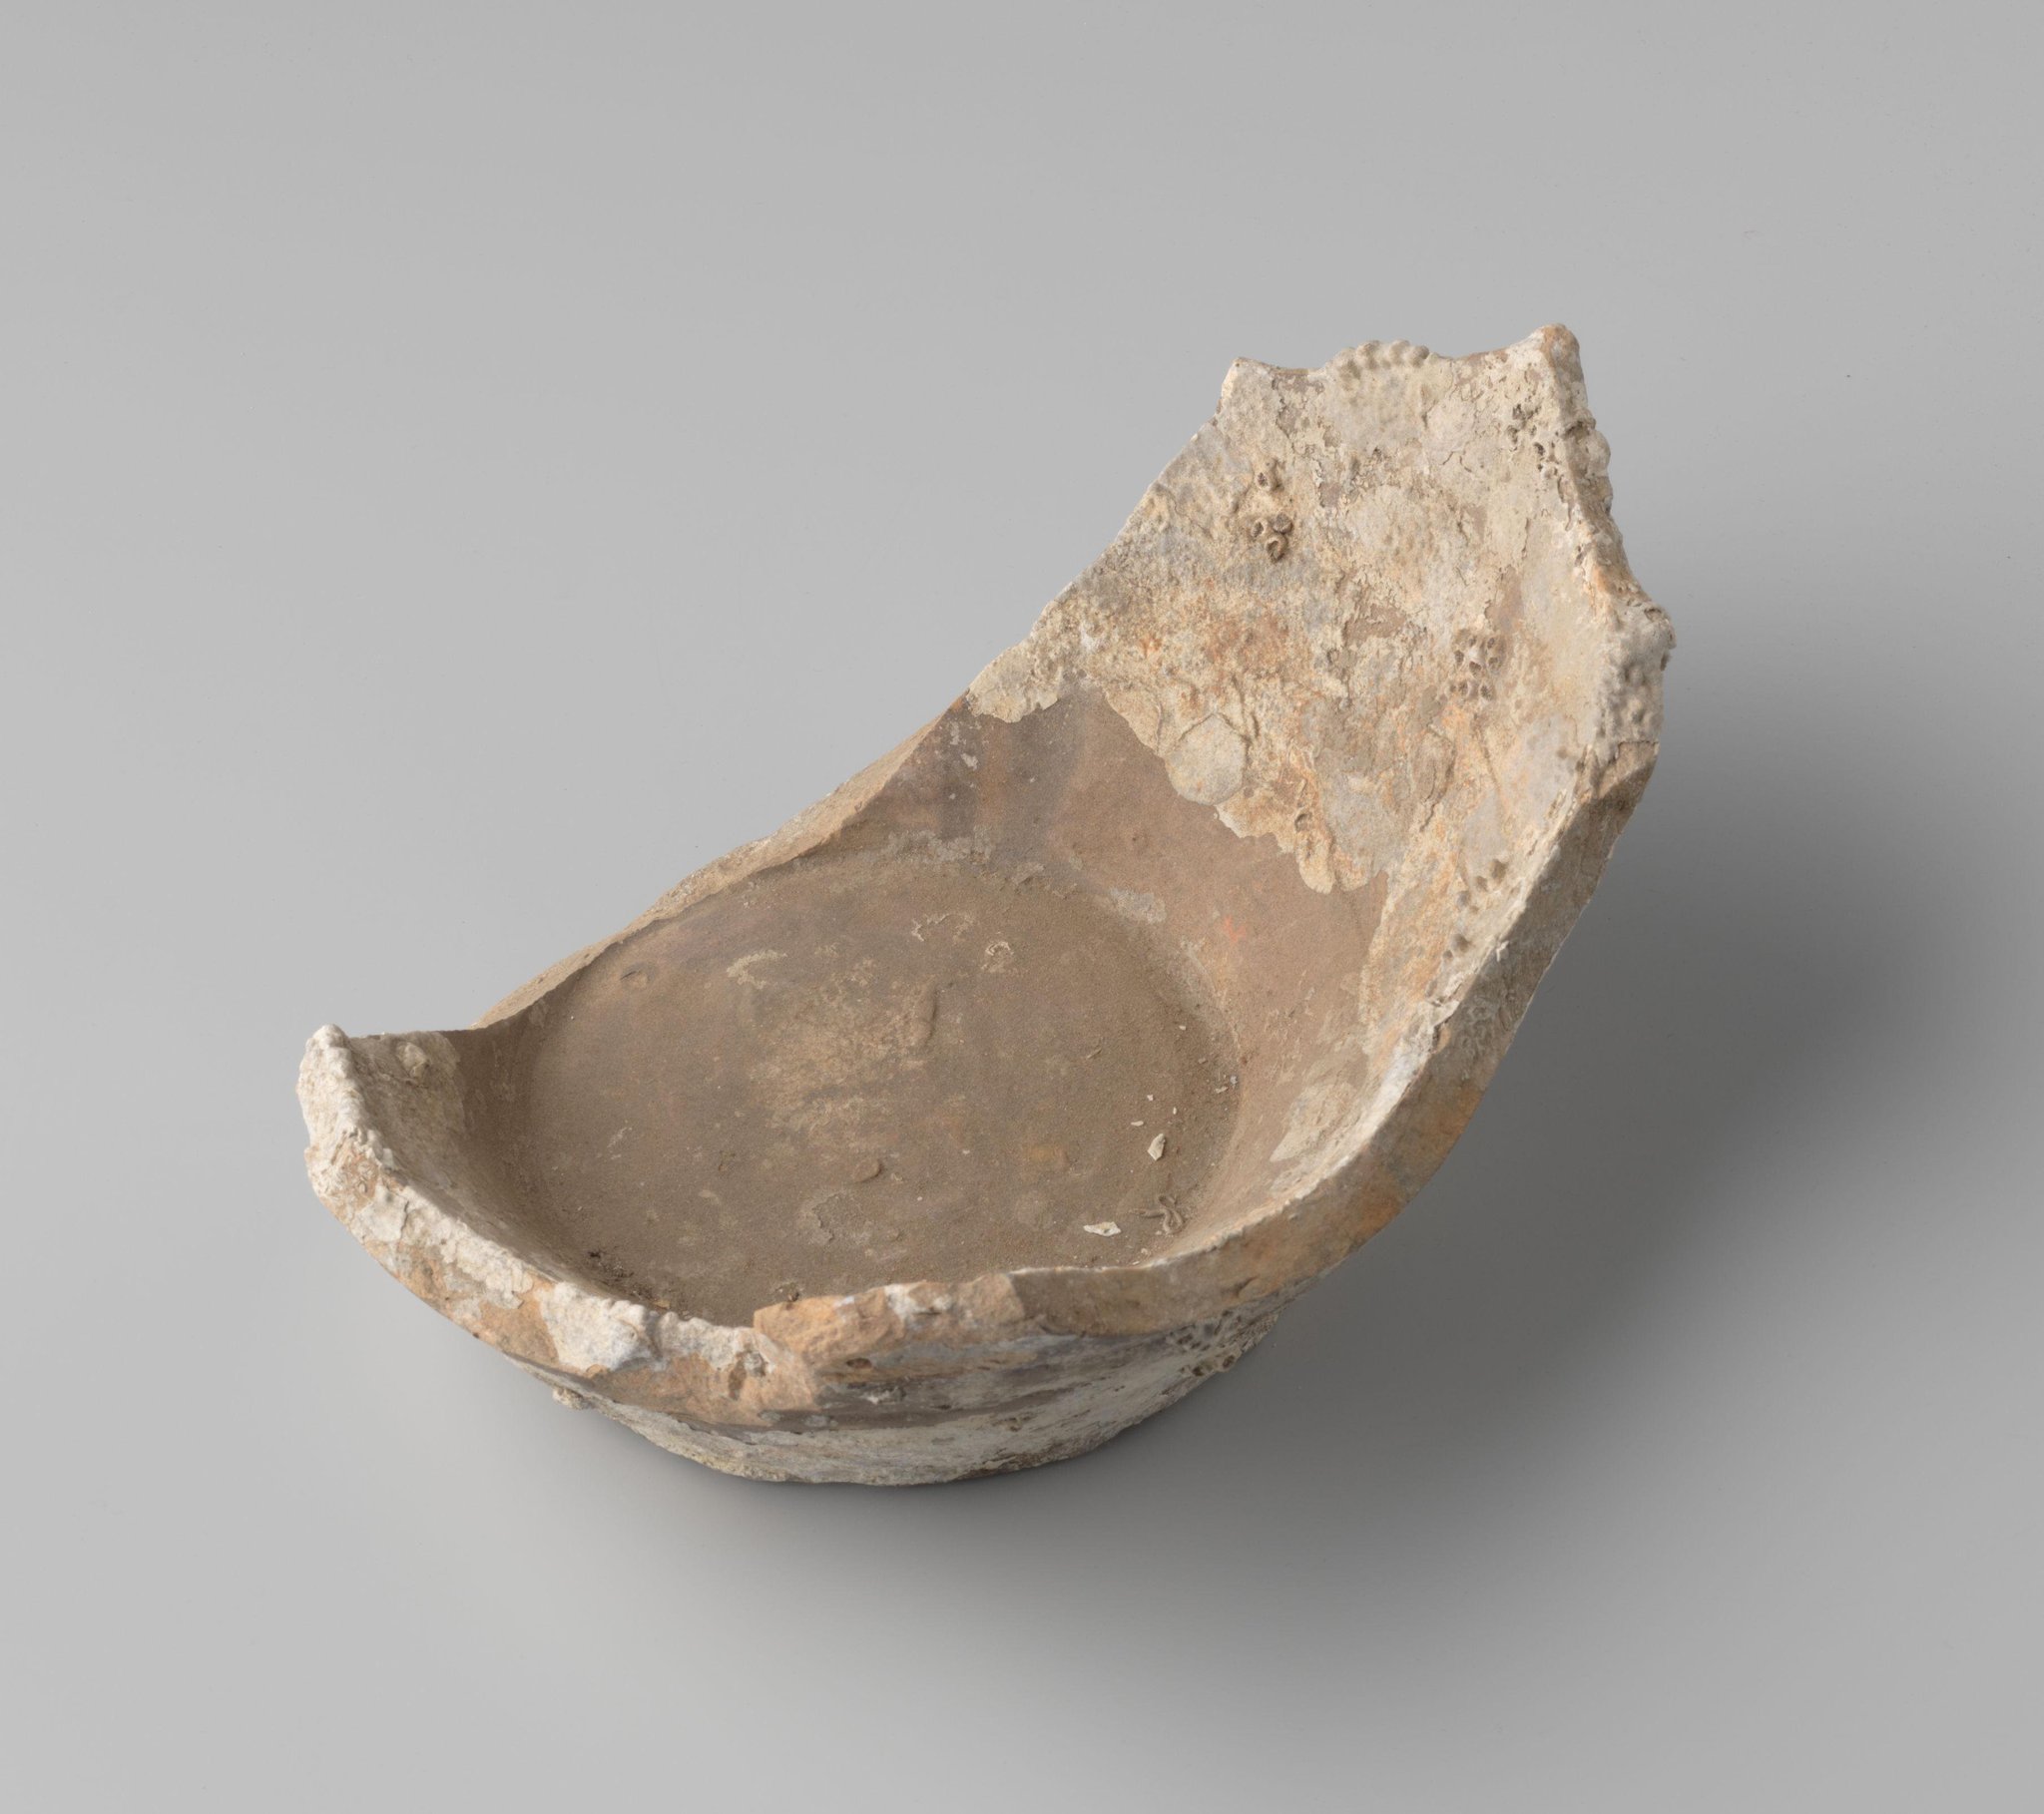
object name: martavaan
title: Scherf van martavaan uit V.O.C.-schip 'Witte Leeuw'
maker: Anonymous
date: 1613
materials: porcelain, stoneware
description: Bodemfragment martavaan uit V.O.C.-schip 'Witte Leeuw'.